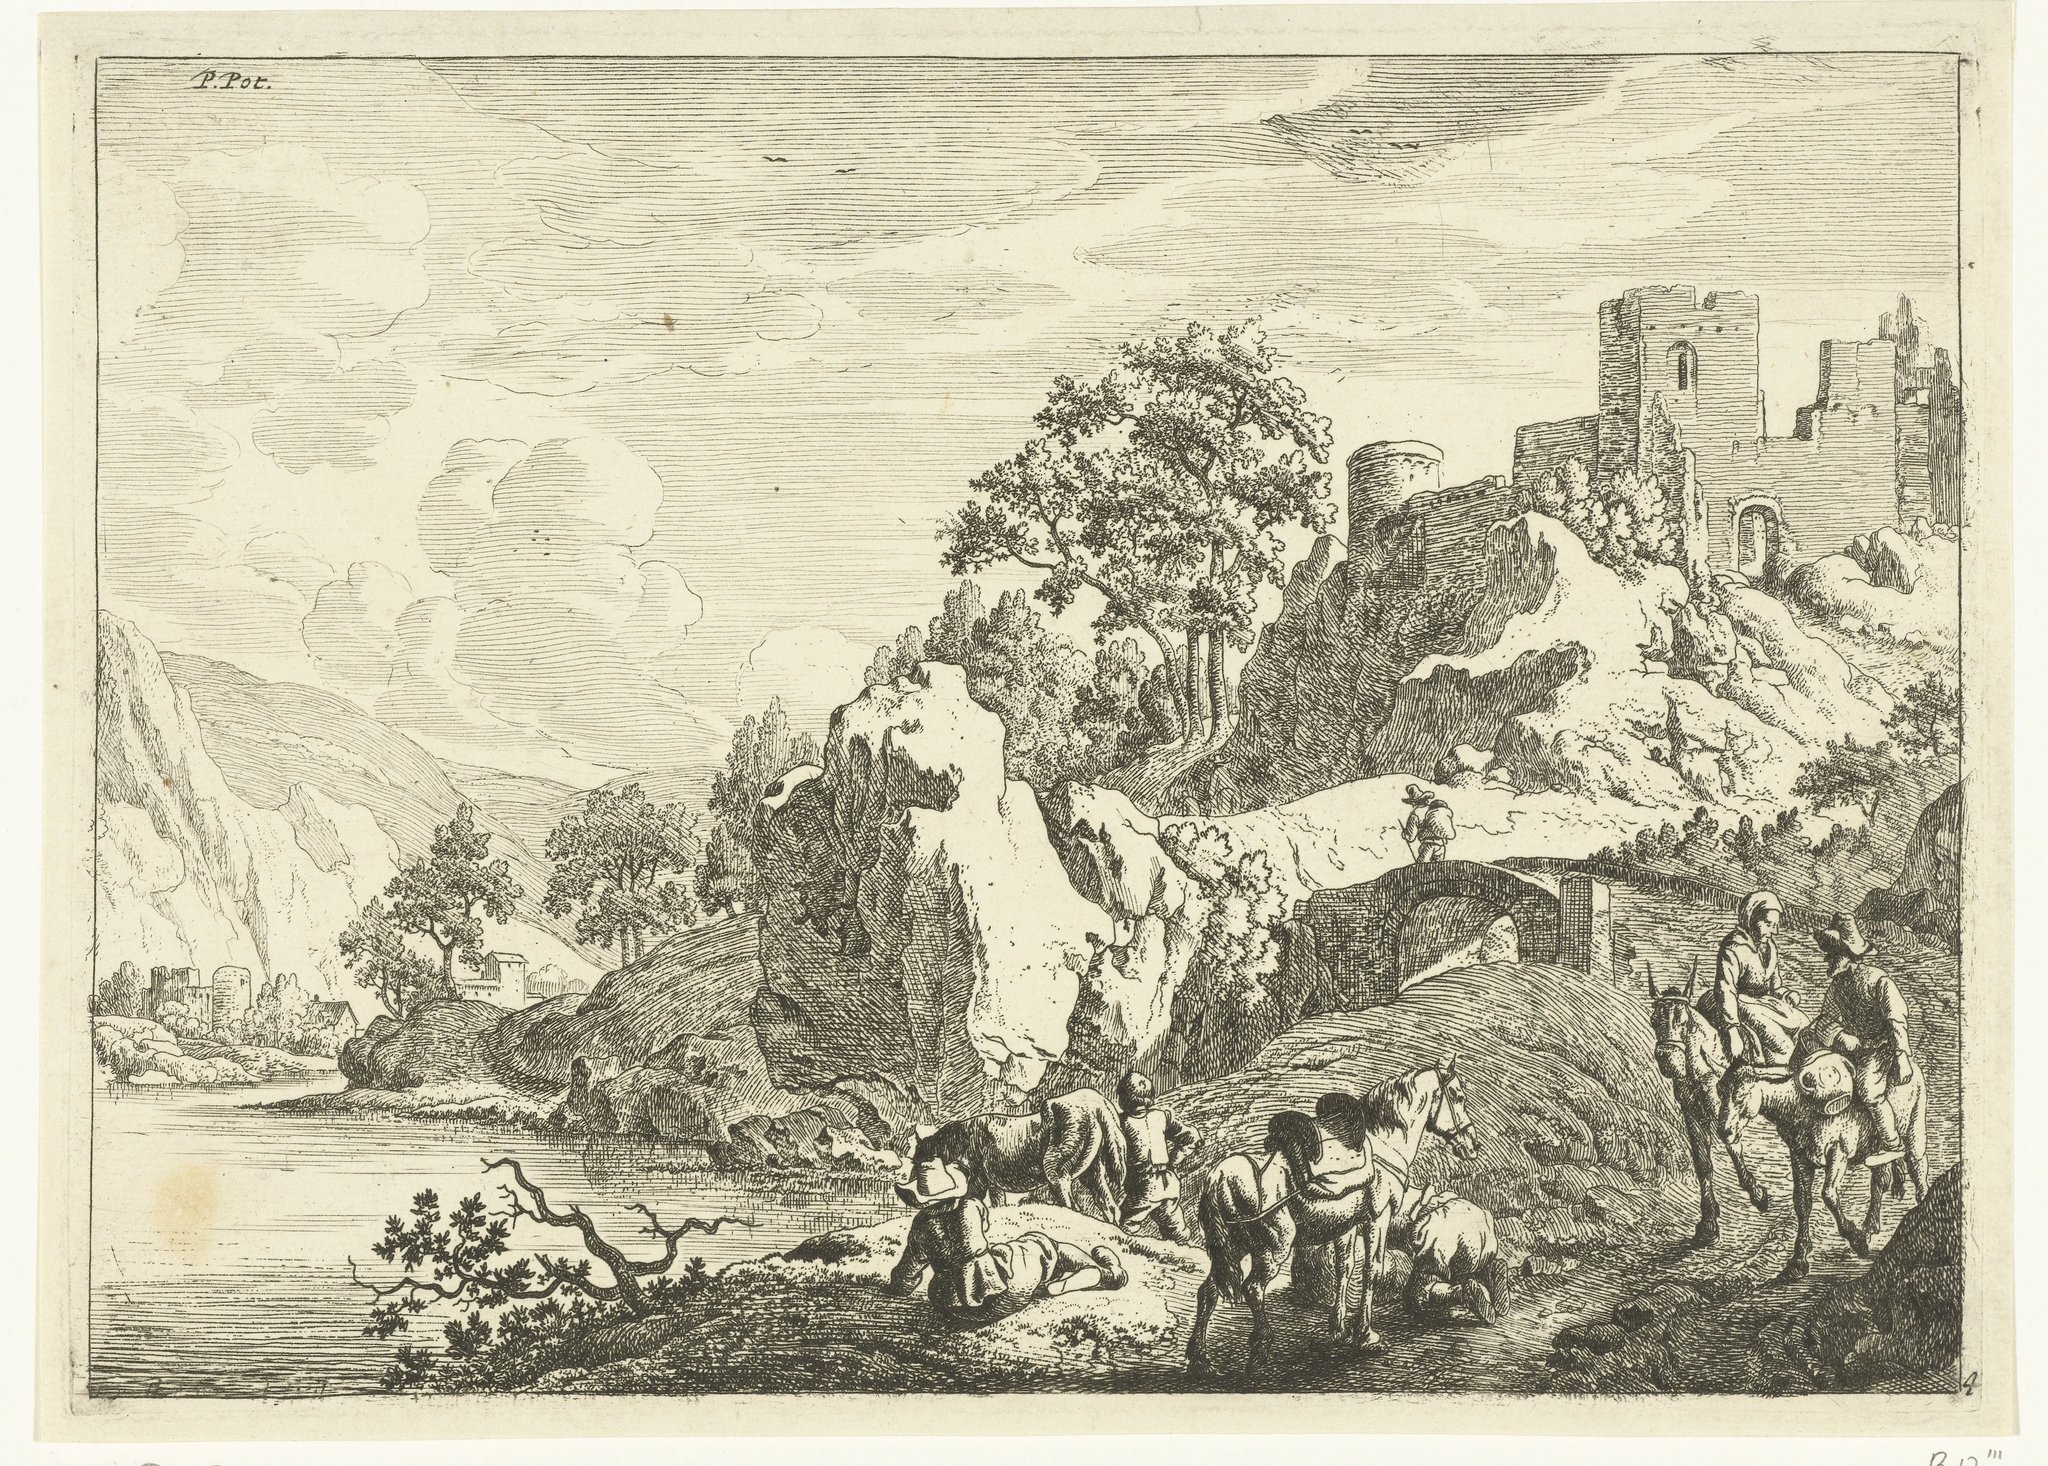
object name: print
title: Landschap met reizigers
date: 1624-1661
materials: paper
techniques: engraving, etching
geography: amsterdam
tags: road, path, mountains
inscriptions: collector's mark: Lugt 240, collector's mark: Lugt 1838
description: Berglandschap met rustende reizigers aan de oever van een water. Rechts een burcht op een rots.